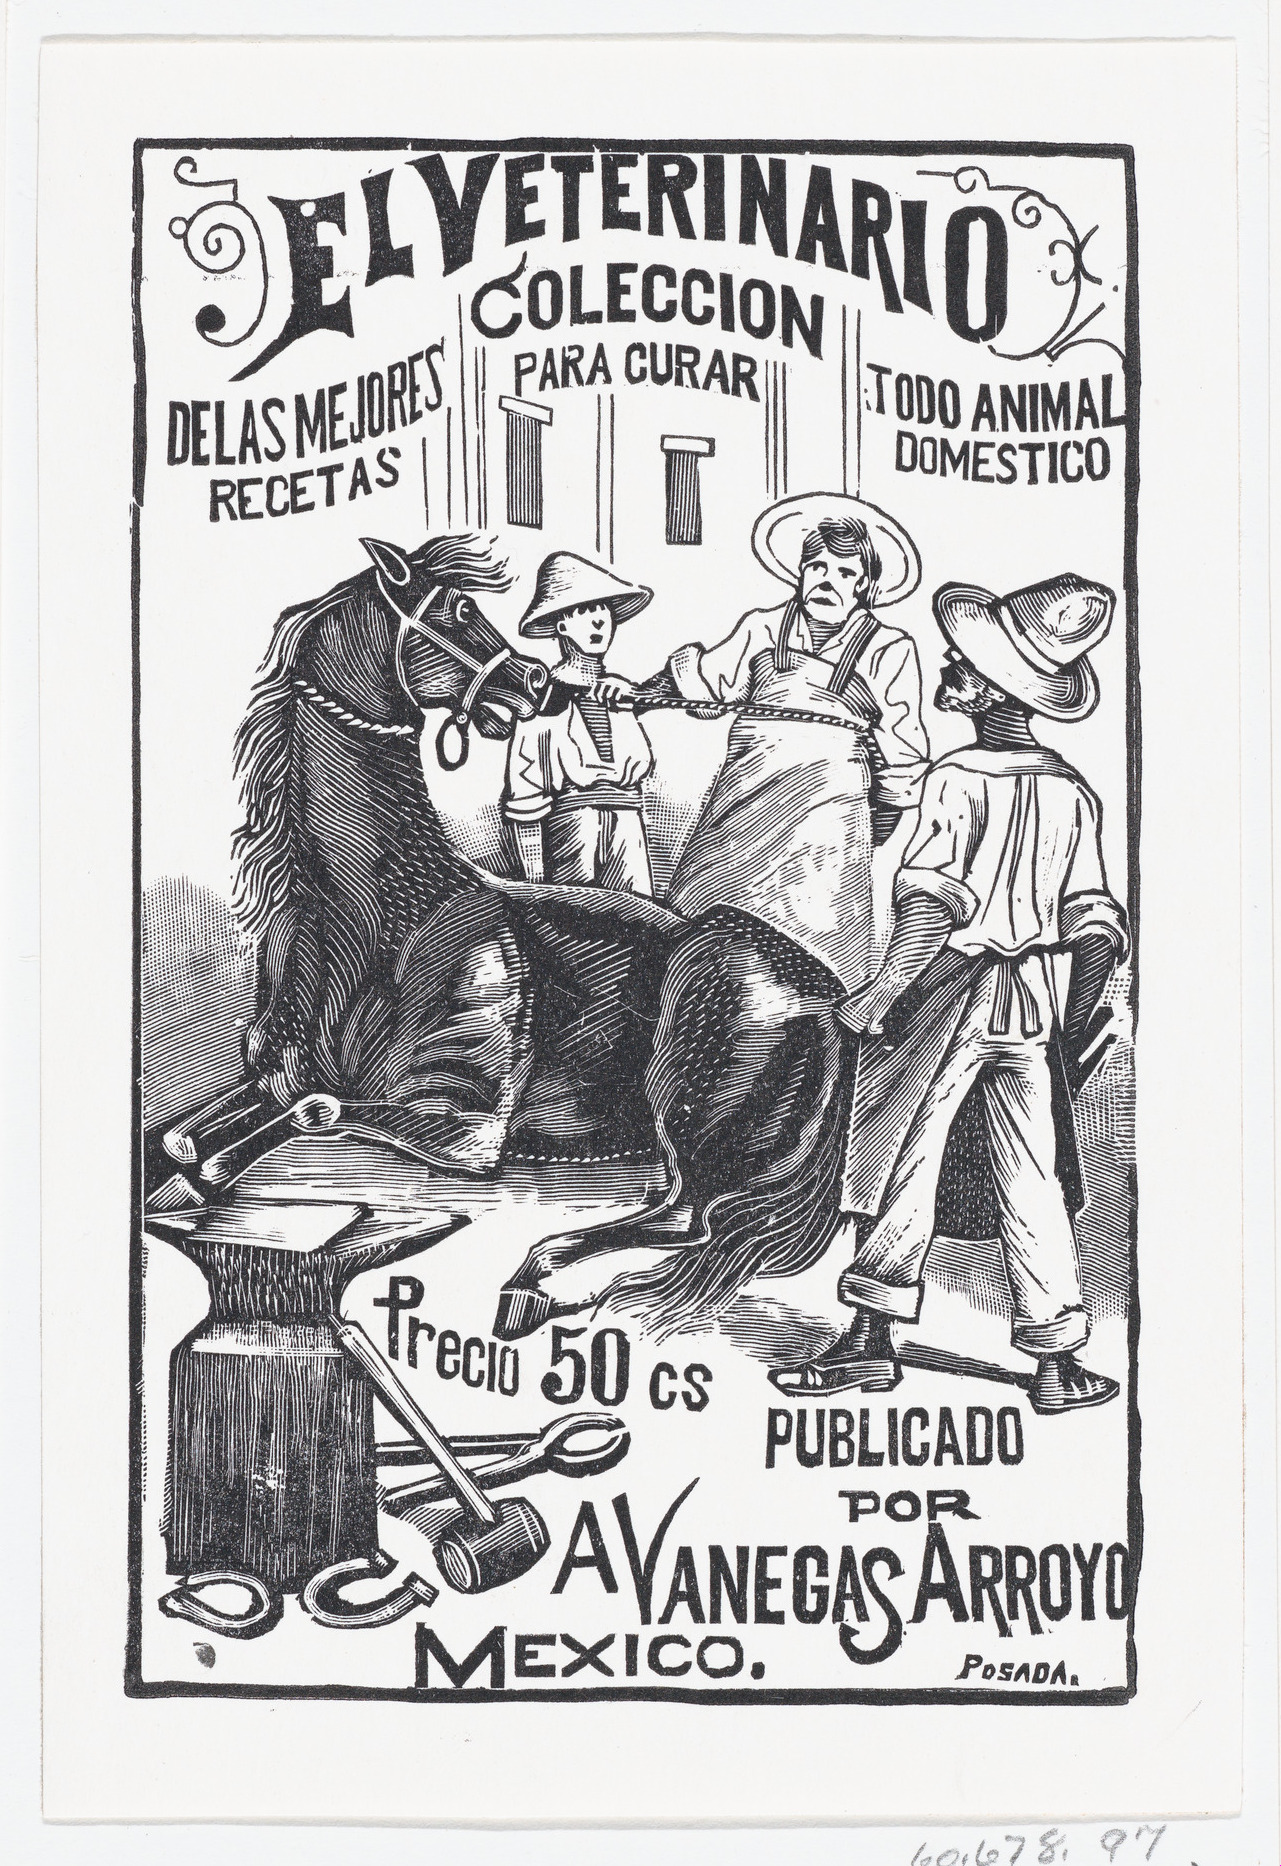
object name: print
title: A group of people surrounding a horse, illustration for 'El Veterinario (The Veterinary: Collection of the best prescriptions for curing all domestic animals)' published by Antonio Vanegas Arroyo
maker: josé guadalupe posada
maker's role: artist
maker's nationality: mexican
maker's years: 1852-1913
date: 1880-1910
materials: metal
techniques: engraving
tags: men,horses